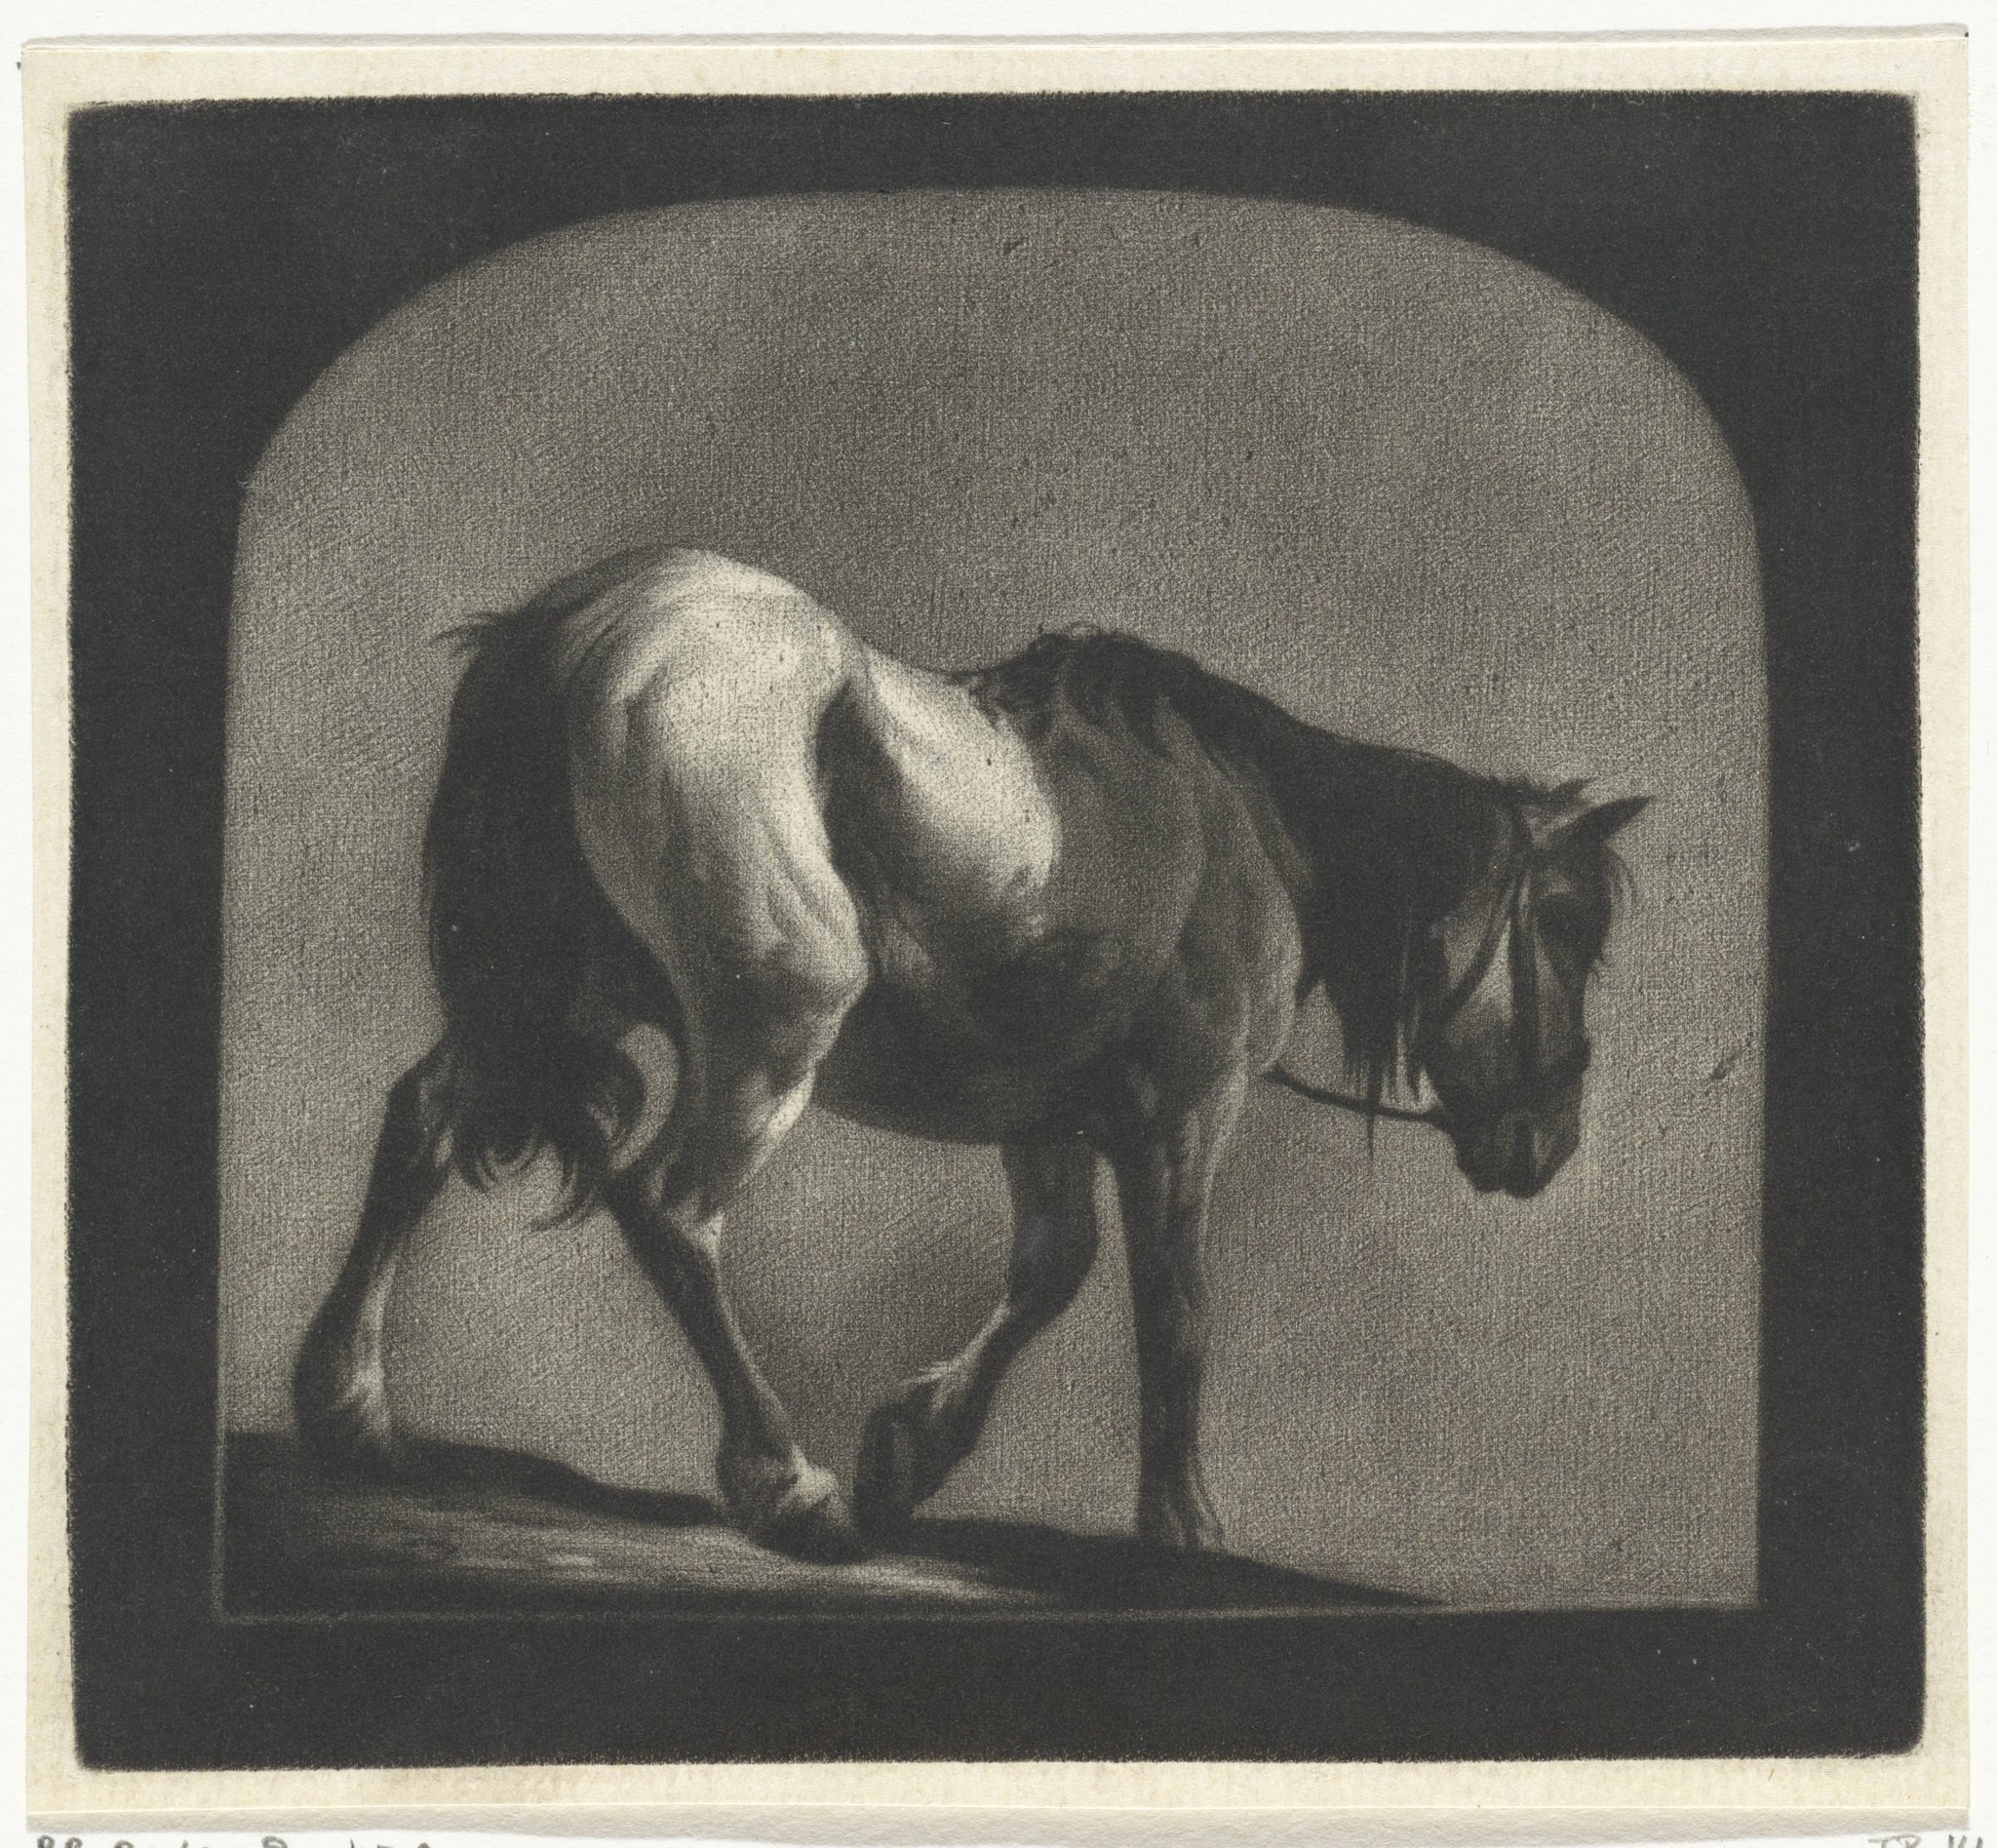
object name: print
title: Lopend paard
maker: arnout rentinck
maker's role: draughtsman, print maker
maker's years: 1712-1774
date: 1722-1775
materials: paper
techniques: mezzotint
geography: amsterdam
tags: horses and kindred animals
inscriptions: collector's mark: Lugt 2228